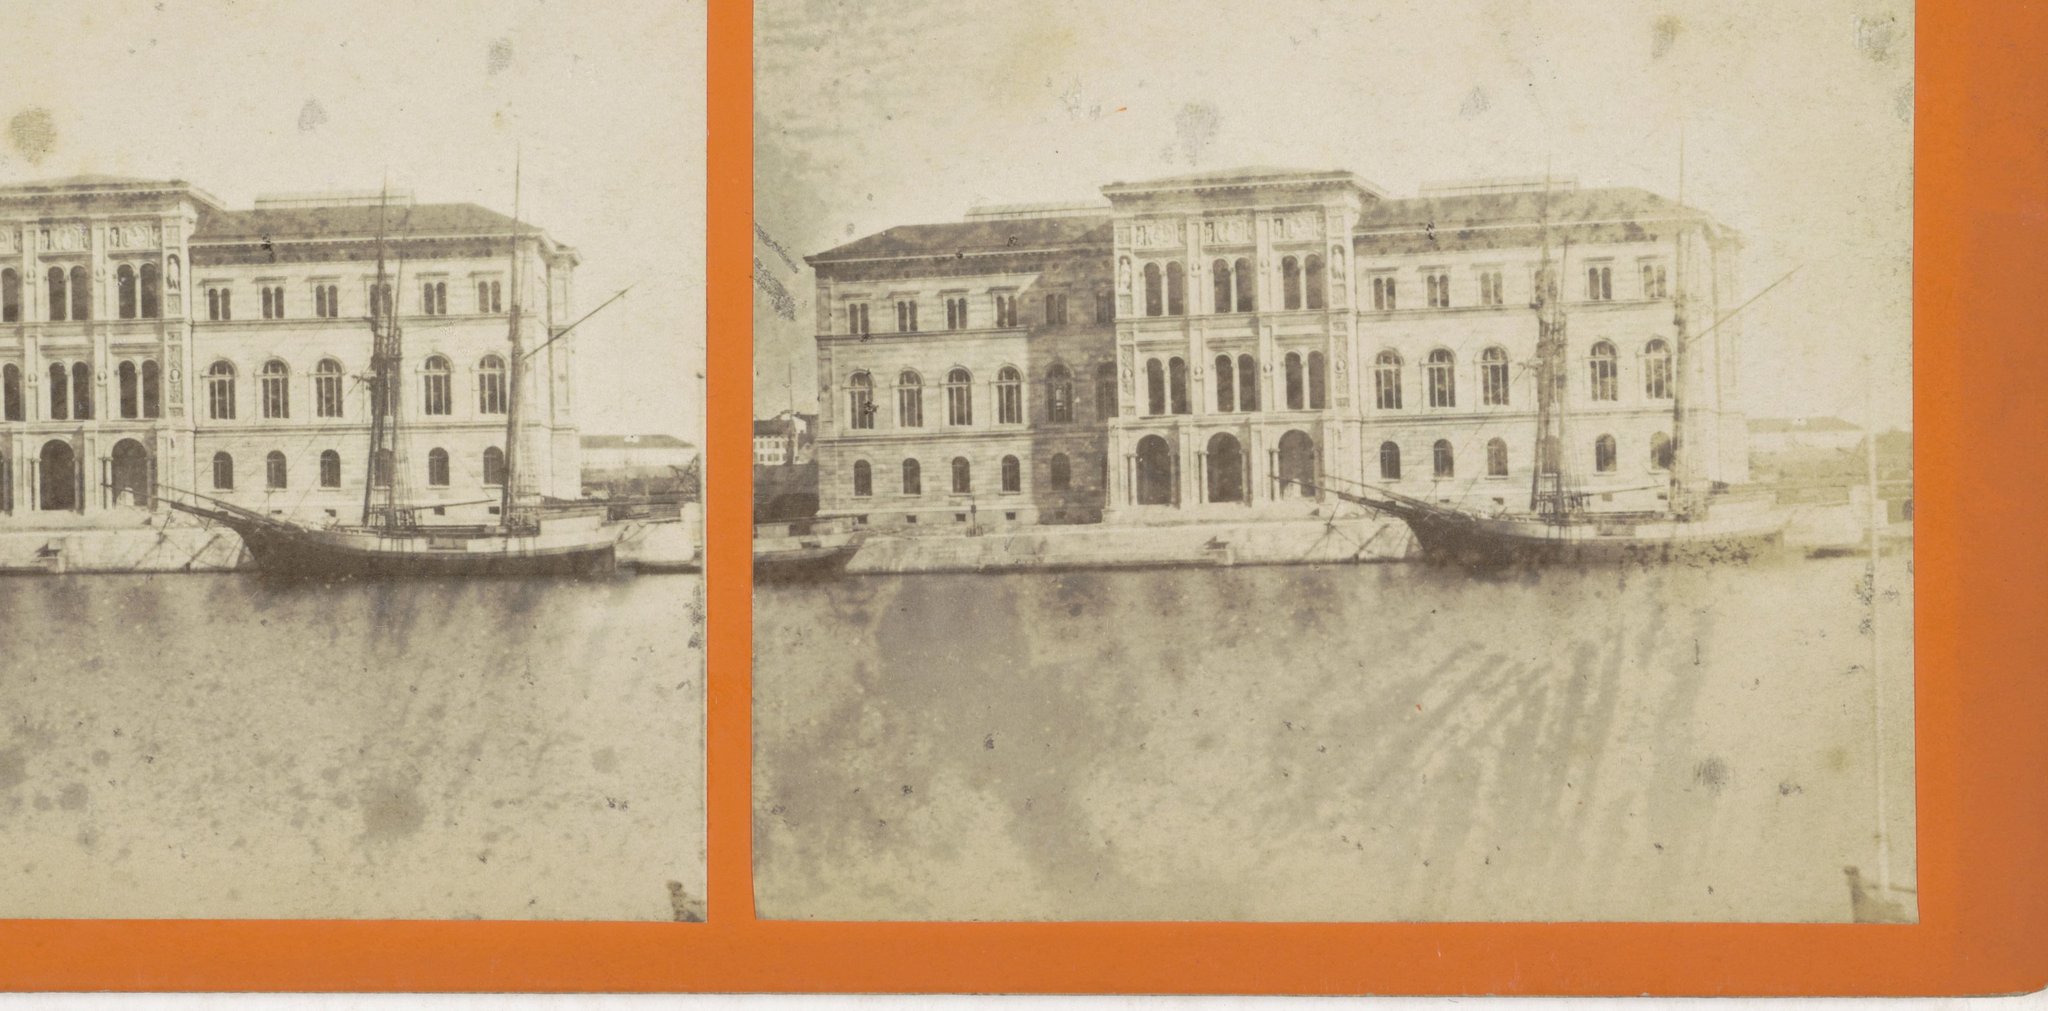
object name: stereograph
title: Nationalmuseum in Stockholm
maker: Anonymous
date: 1868-1880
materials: cardboard, paper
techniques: albumen print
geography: stockholm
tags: permanent exhibition, museum